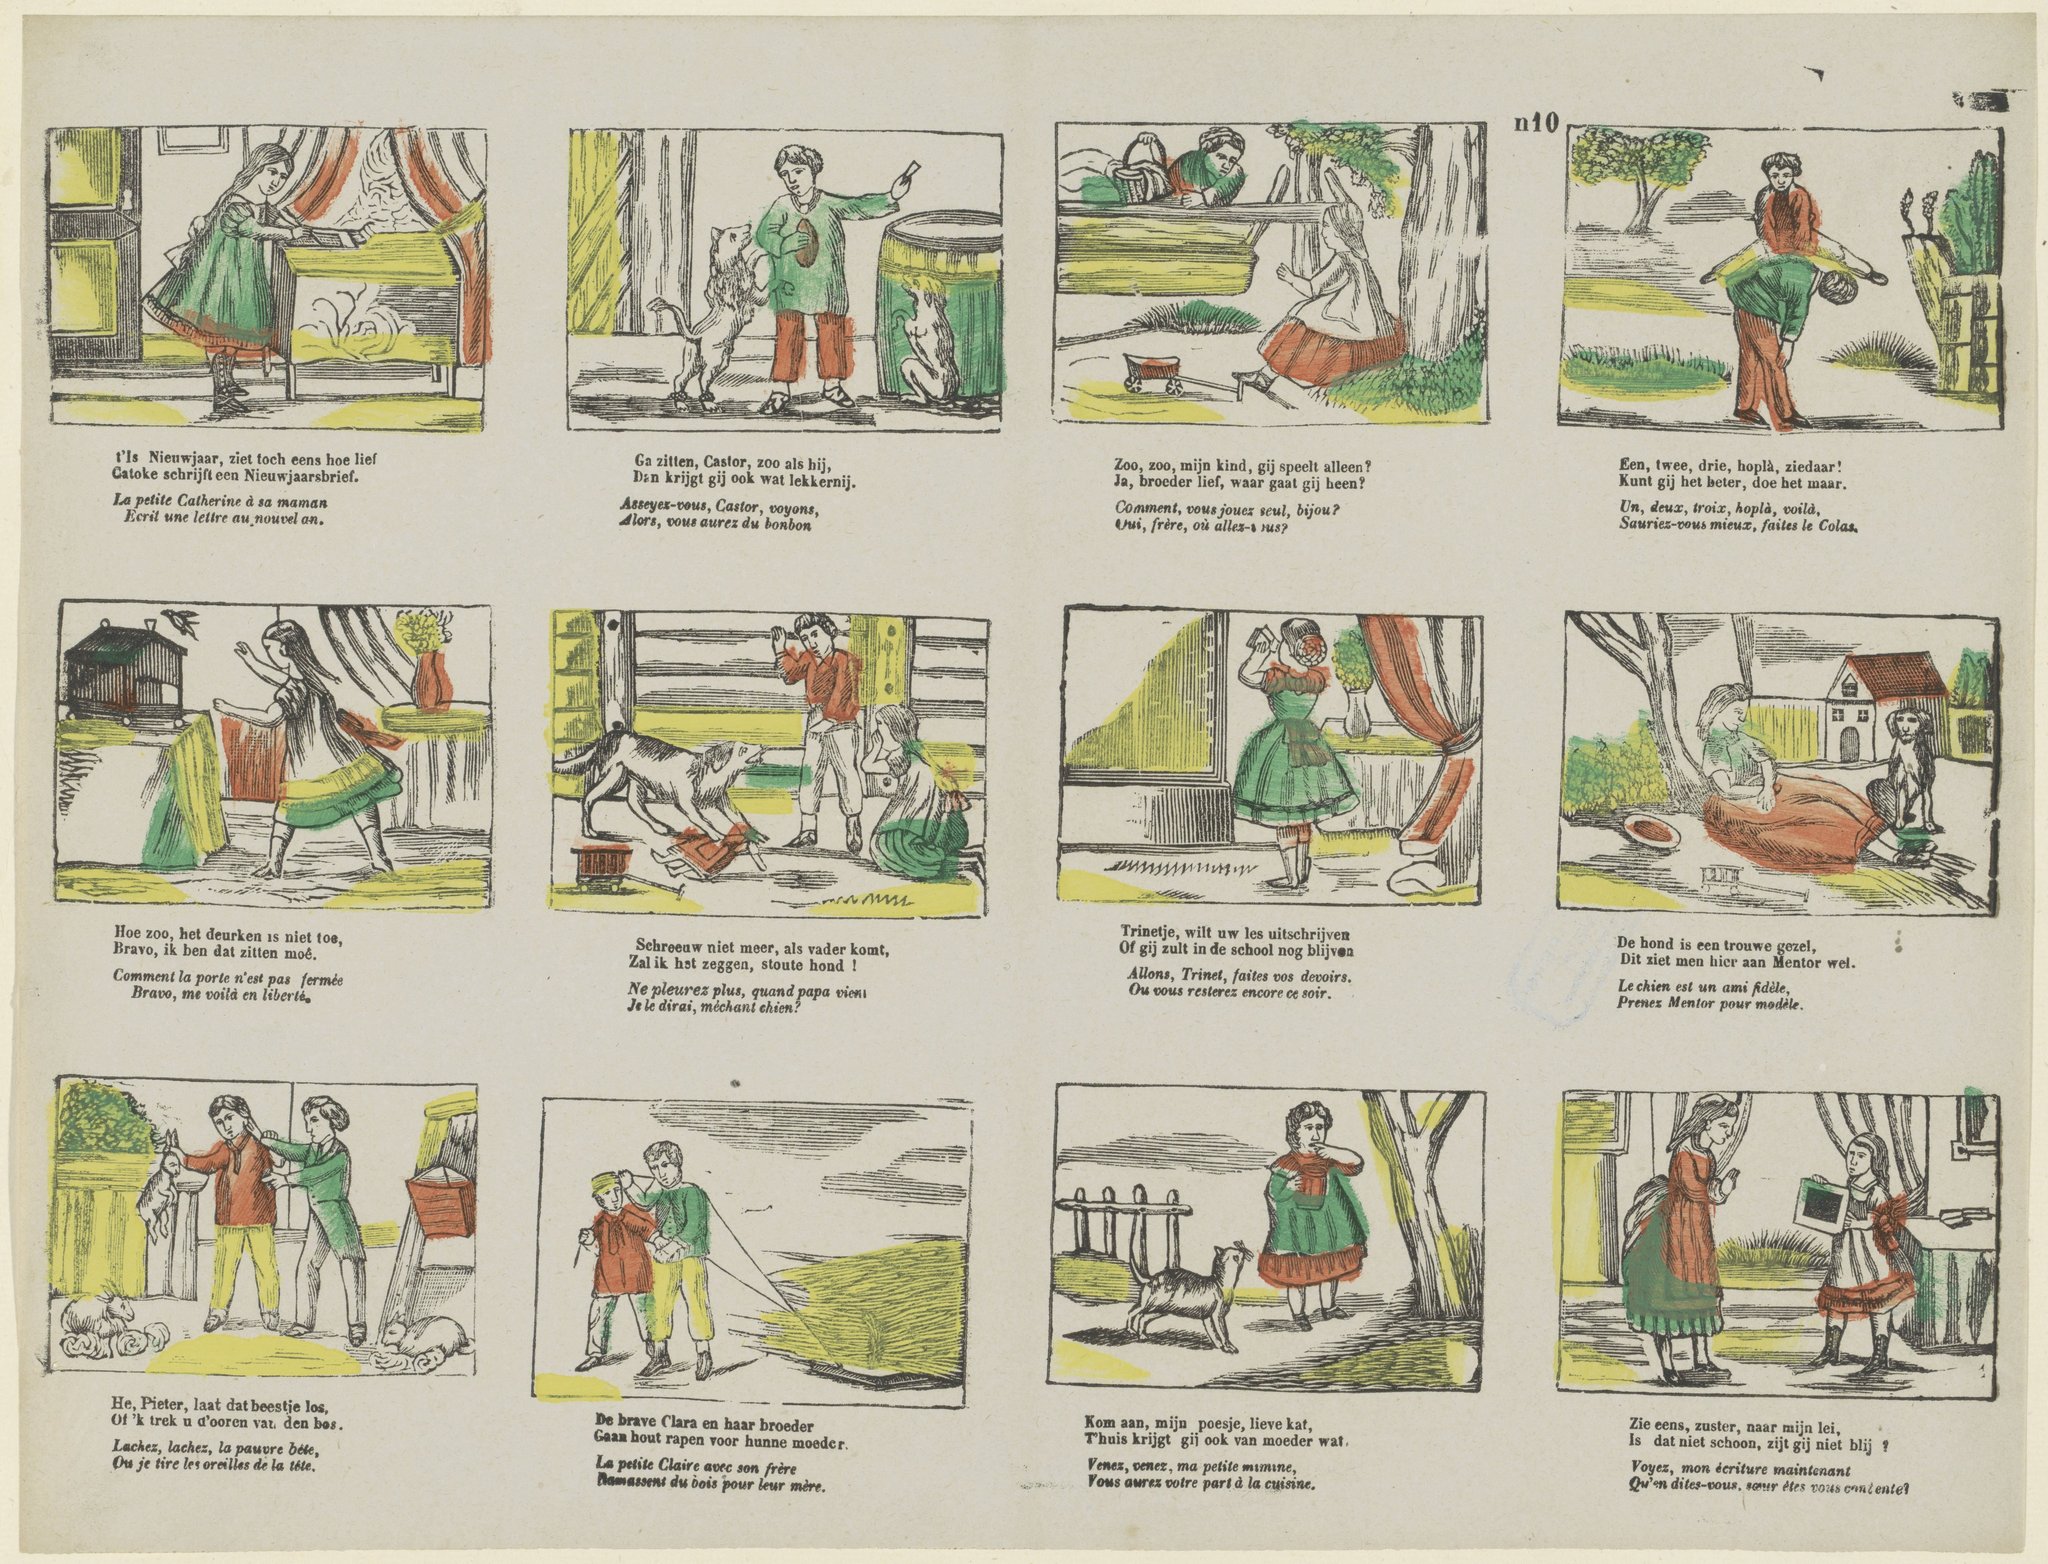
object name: print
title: Kinderbezigheden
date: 1866-1902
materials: paper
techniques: colour, letterpress printing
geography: turnhout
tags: education, science and learning, children's games and plays, child, child playing with animals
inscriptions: collector's mark: Lugt 2760, collector's mark: ‘Edw. Ipers / Oever 27, / Antwerpen.’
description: Blad met 12 voorstellingen van kinderbezigheden, waaronder spelen met dieren, spelen met andere kinderen en studeren. Onder elke voorstelling een tweeregelig vers in het Nederlands en in het Frans. Genummerd midden boven: n 10.